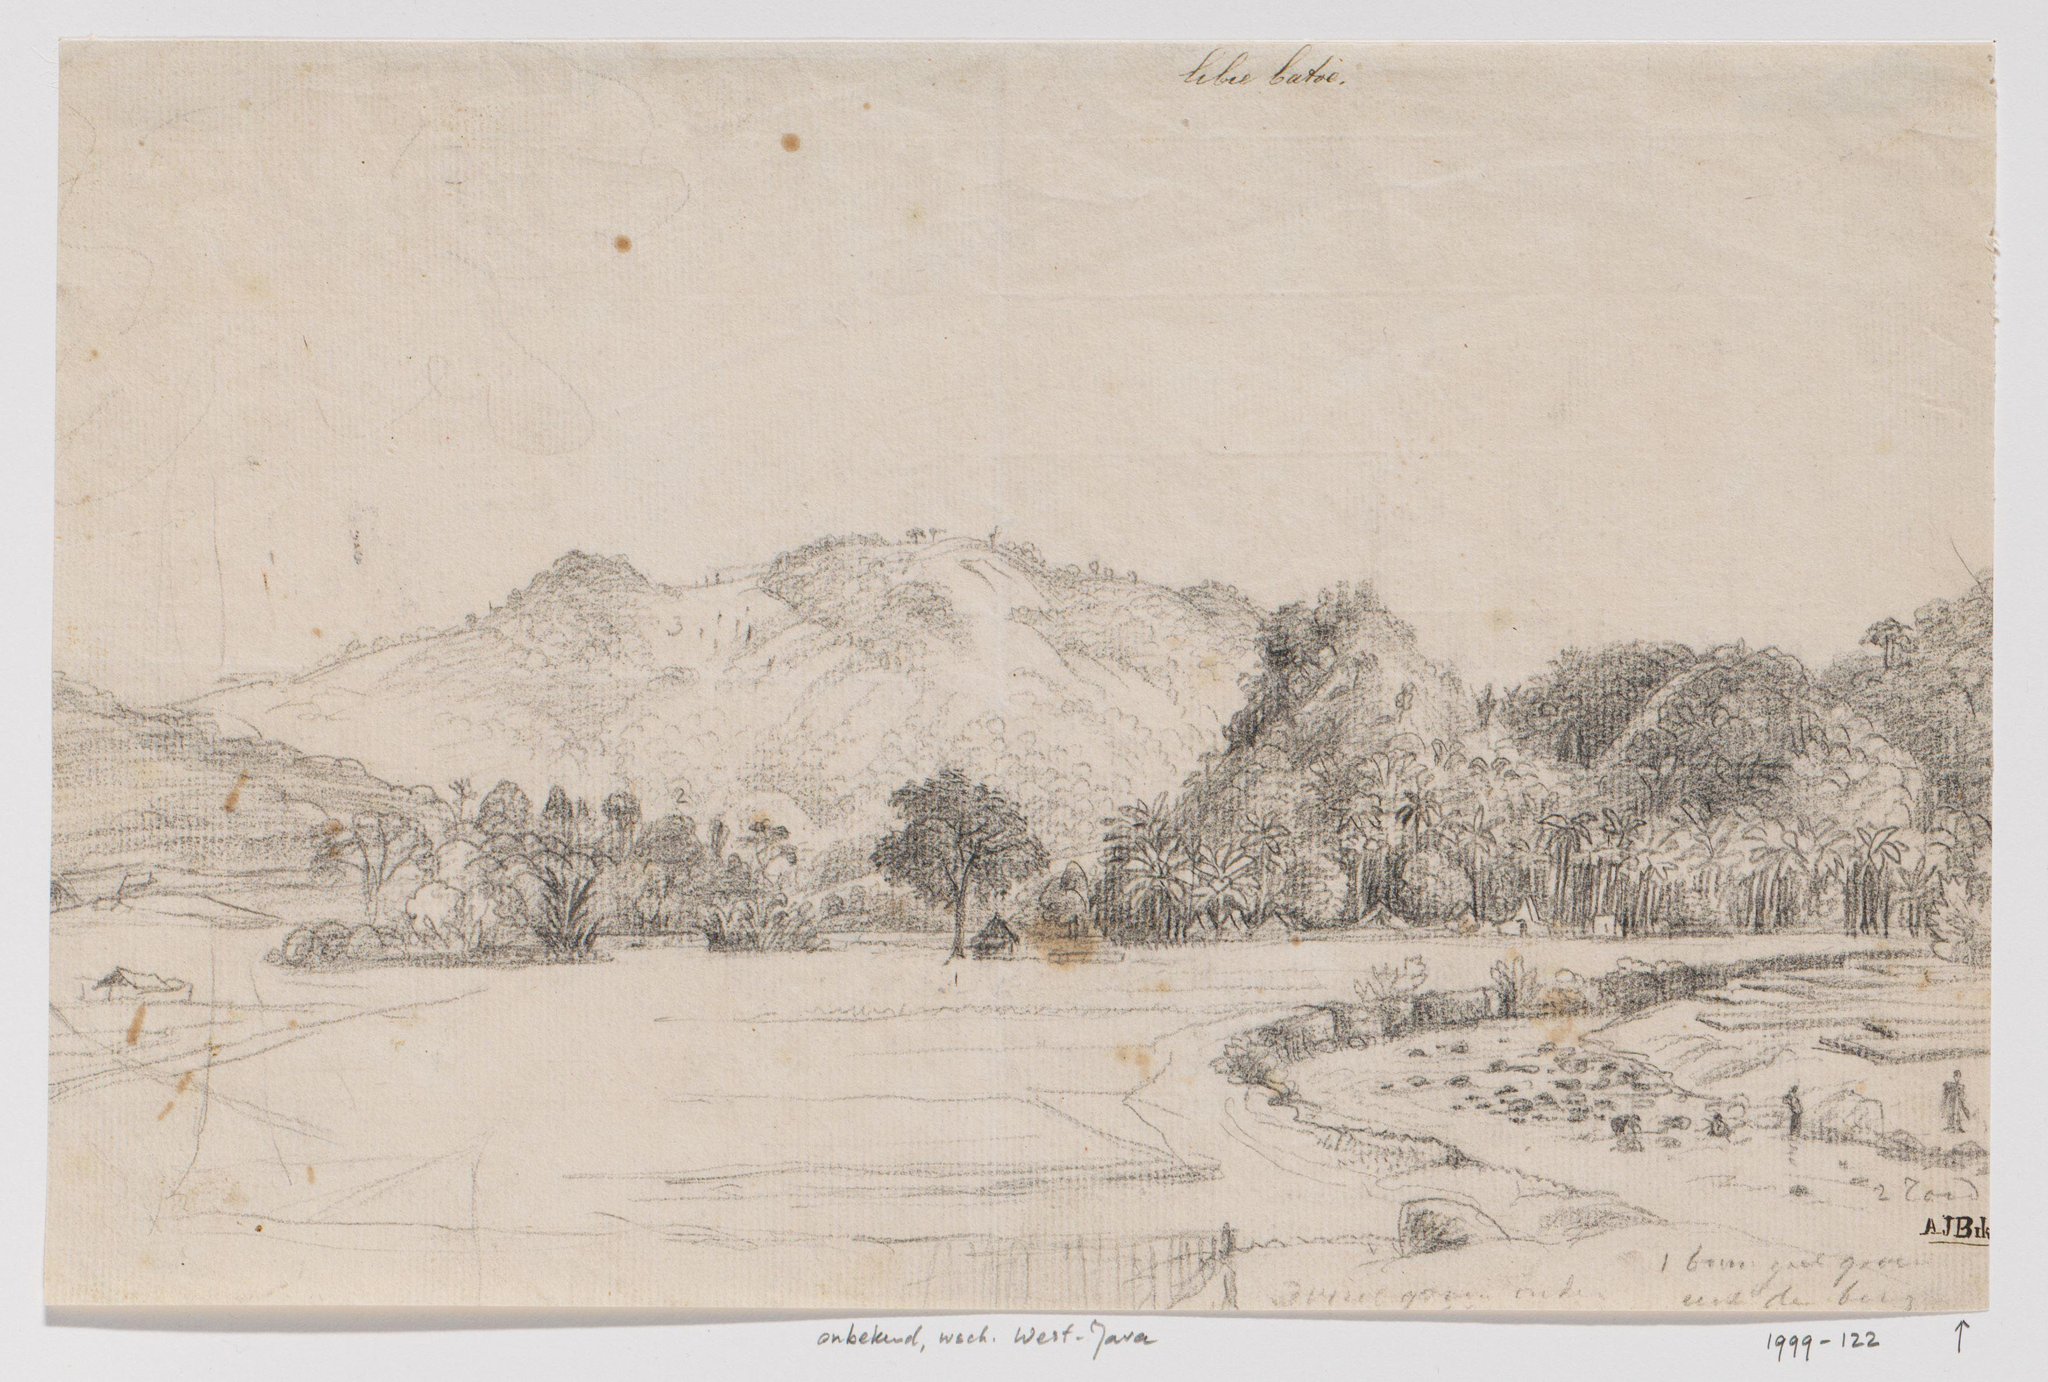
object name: topographical view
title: Landschap met rivier en dorp (Leuwibatu), West-Java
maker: adrianus johannes bik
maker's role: draughtsman, print maker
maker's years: 1790-1872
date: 1816-1846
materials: chalk, paper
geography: java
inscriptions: inscription: ‘Tjoeroek Lontar op het land Tji-Ampea by Buitenzorg’, signature: ‘A.J.Bik’, annotation, annotation: ‘Lebie batoe’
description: artikel over deze collectie in Bulletin van het Rijksmuseum 49 [2001], nr. 4, pp 342 e.v., p. 352, afb. 10